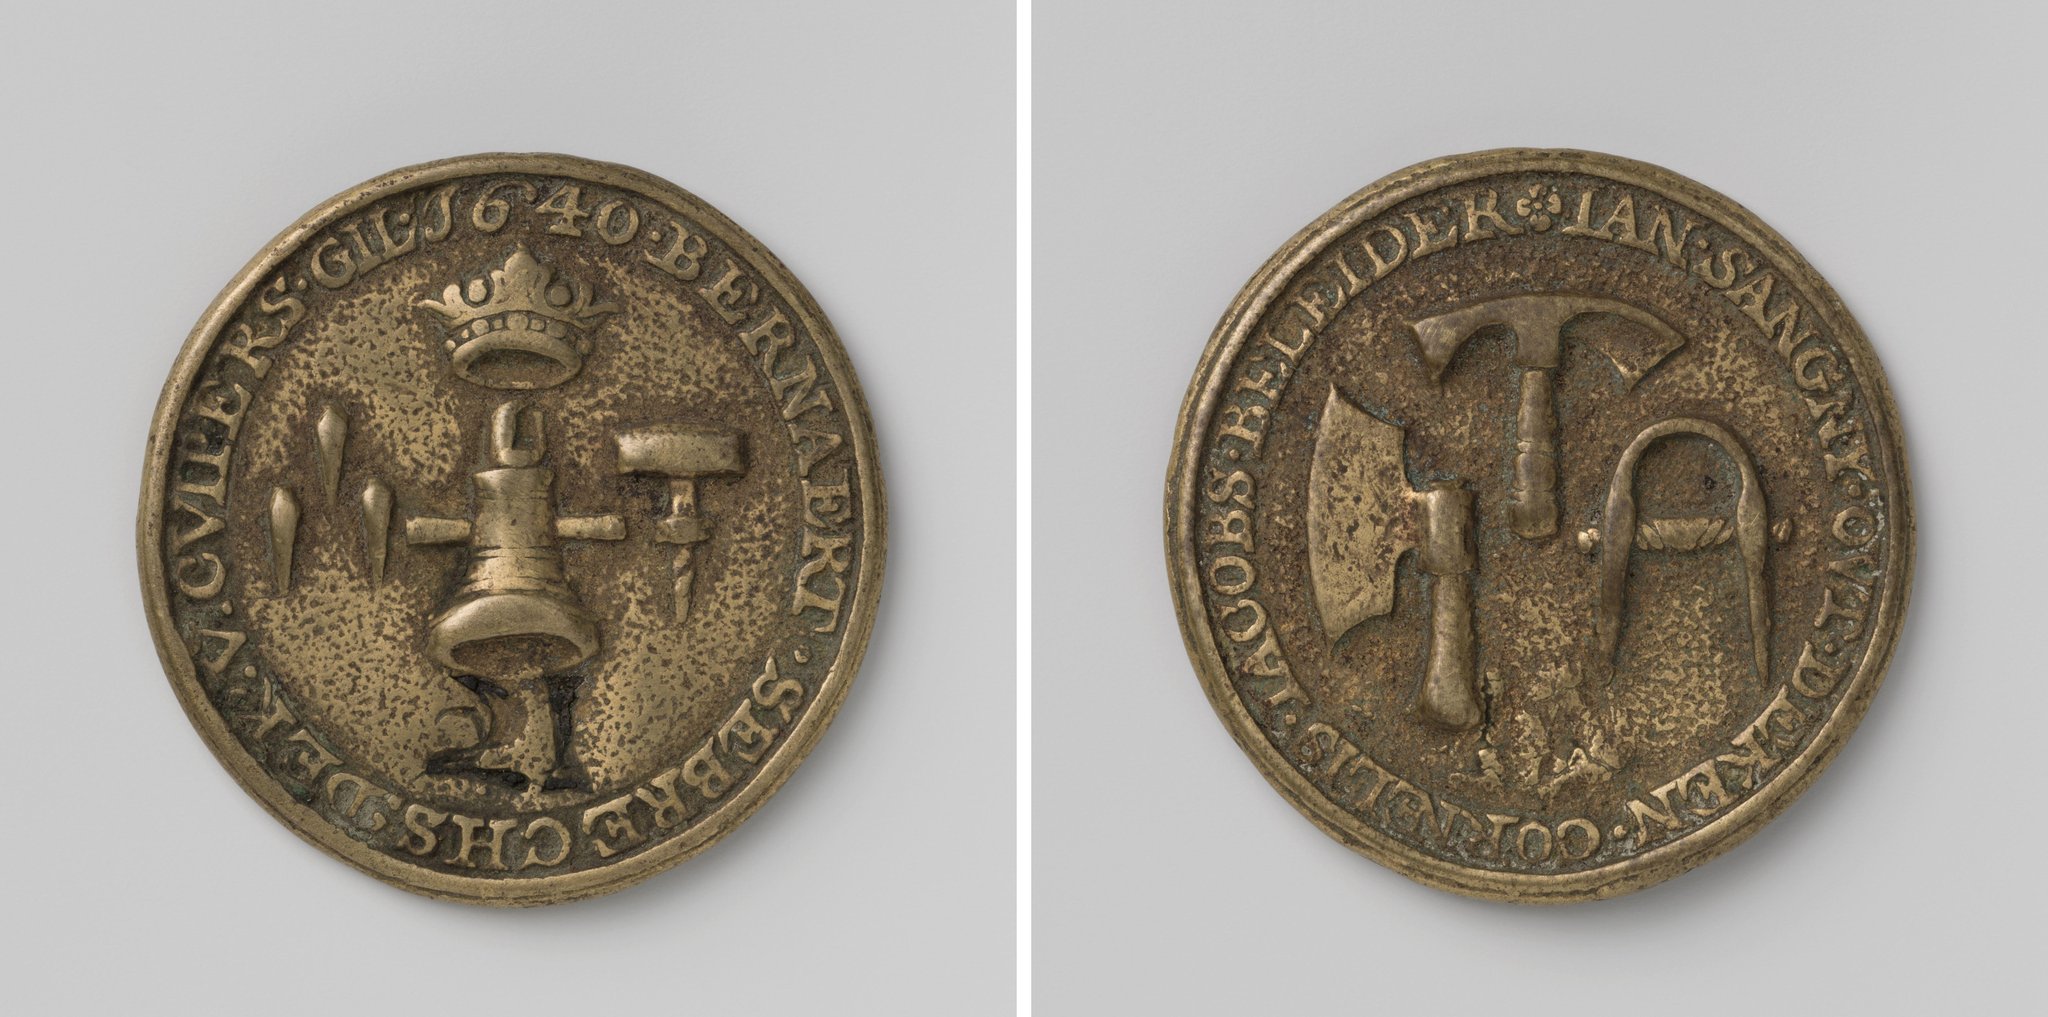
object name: medal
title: Kuipersgilde van Middelburg, gildepenning met no. 21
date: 1640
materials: brass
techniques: casting, engraving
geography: middelburg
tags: middelburg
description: Messing penning. Voorzijde: gekroond kuipersaambeeeld tussen jaartal, geflankeerd door drie aandrijvers en een boor boven cijfer 21 binnen omschrift. Keerzijde: bijl, kuipershamer en kuiperspasser binnen omschrift